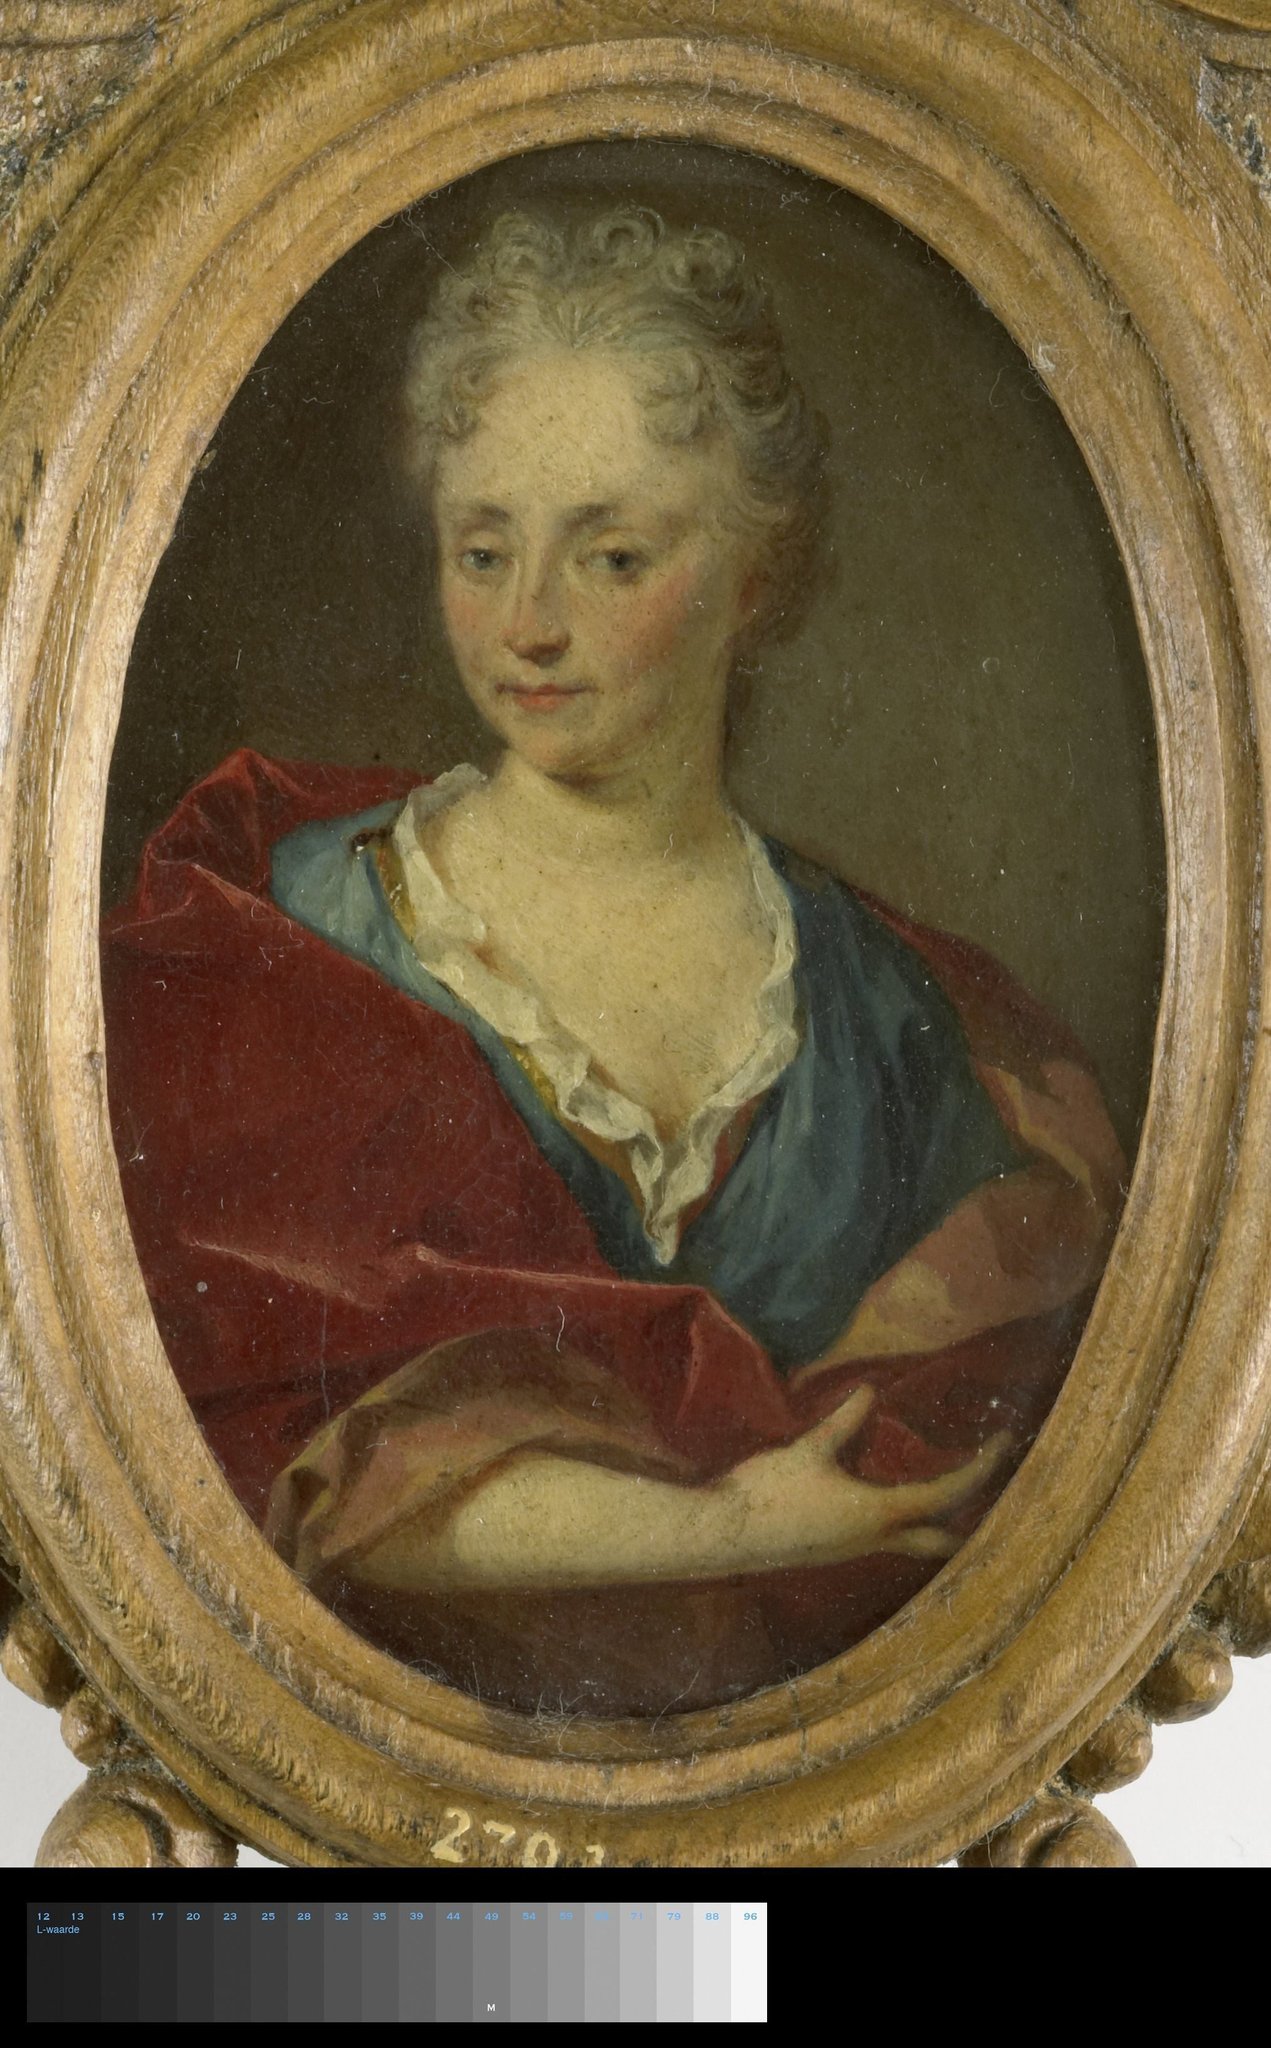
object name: painting, miniature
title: Portret van een vrouw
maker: arnold boonen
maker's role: draughtsman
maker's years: 1669-1729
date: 1710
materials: oil, silver, wood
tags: historical persons not known by name - bb - woman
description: Attributed to Arnold Boonen (1669 - 1729). Portrait of a woman. Oilpaint on silver, c. 1710. Miss M.E. van den Brink bequest, Velp, 1905.